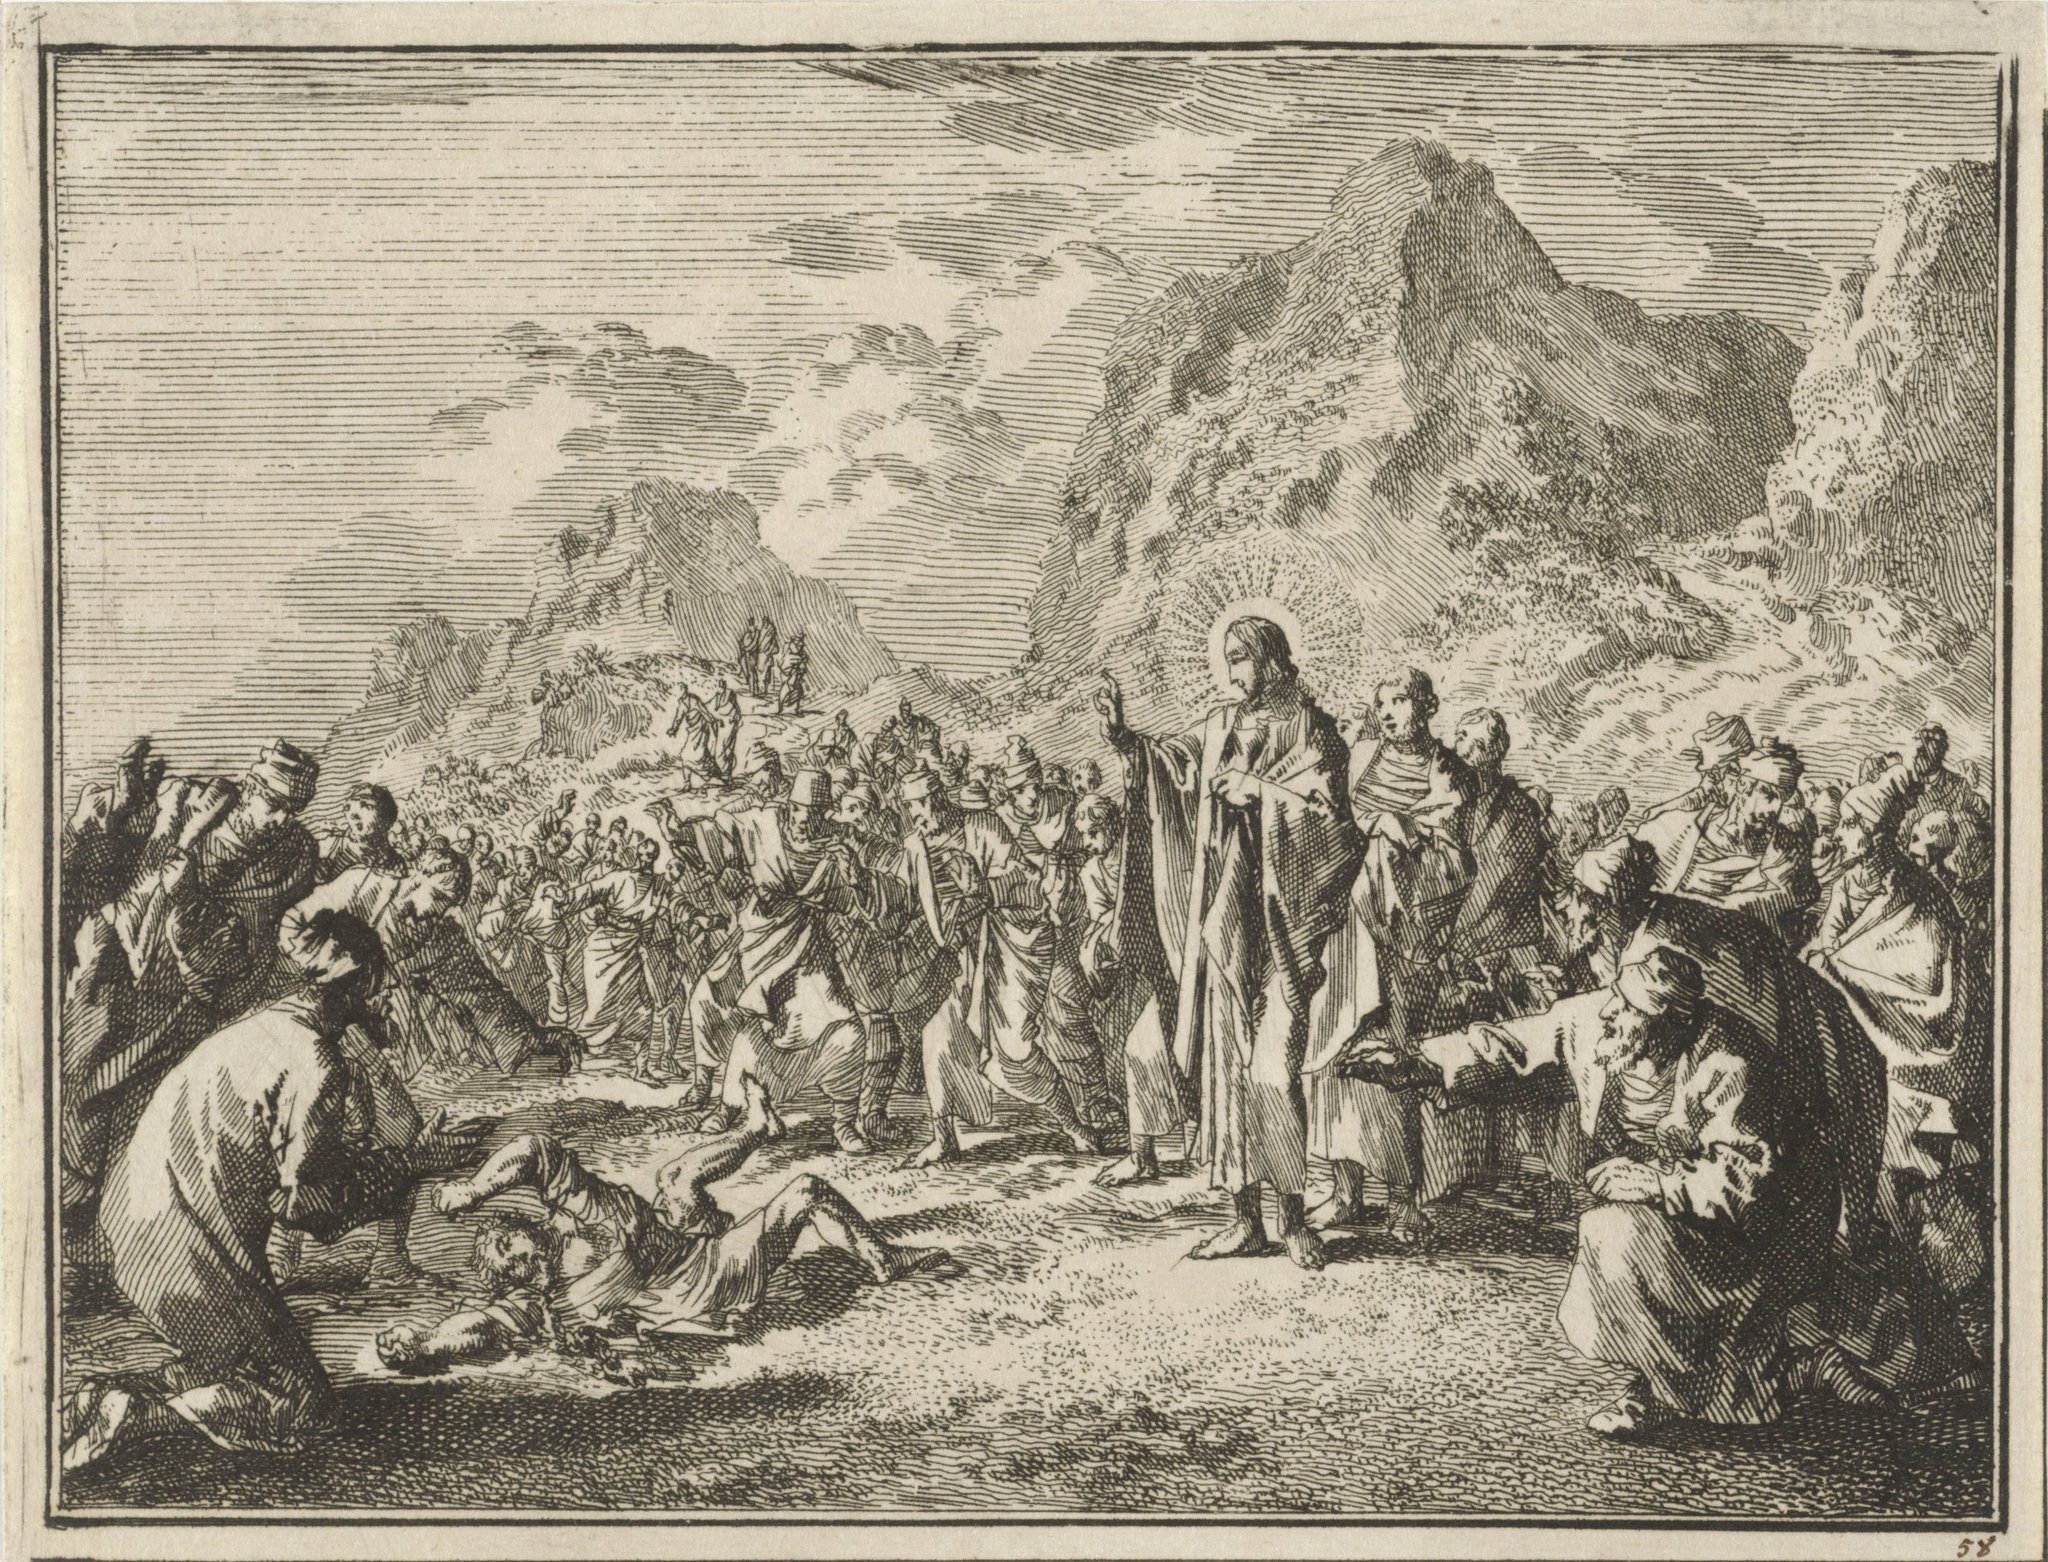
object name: print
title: Christus geneest een bezeten kind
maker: jan luyken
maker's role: draughtsman, print maker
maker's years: 1649-1712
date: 1712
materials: paper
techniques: etching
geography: amsterdam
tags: healing of a lunatic boy (matthew 17:14-21; mark 9:14-29; luke 9:37-43)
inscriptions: number: ‘58’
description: Proefdruk van illustratie uit: Luyken, Jan. De schriftuurlyke geschiedenissen en gelykenissen van het Oude en Nieuwe Verbond, 2 delen. Amsterdam: Wed. Pieter Arentsz II en Cornelis van der Sys, 1712, dl. II.